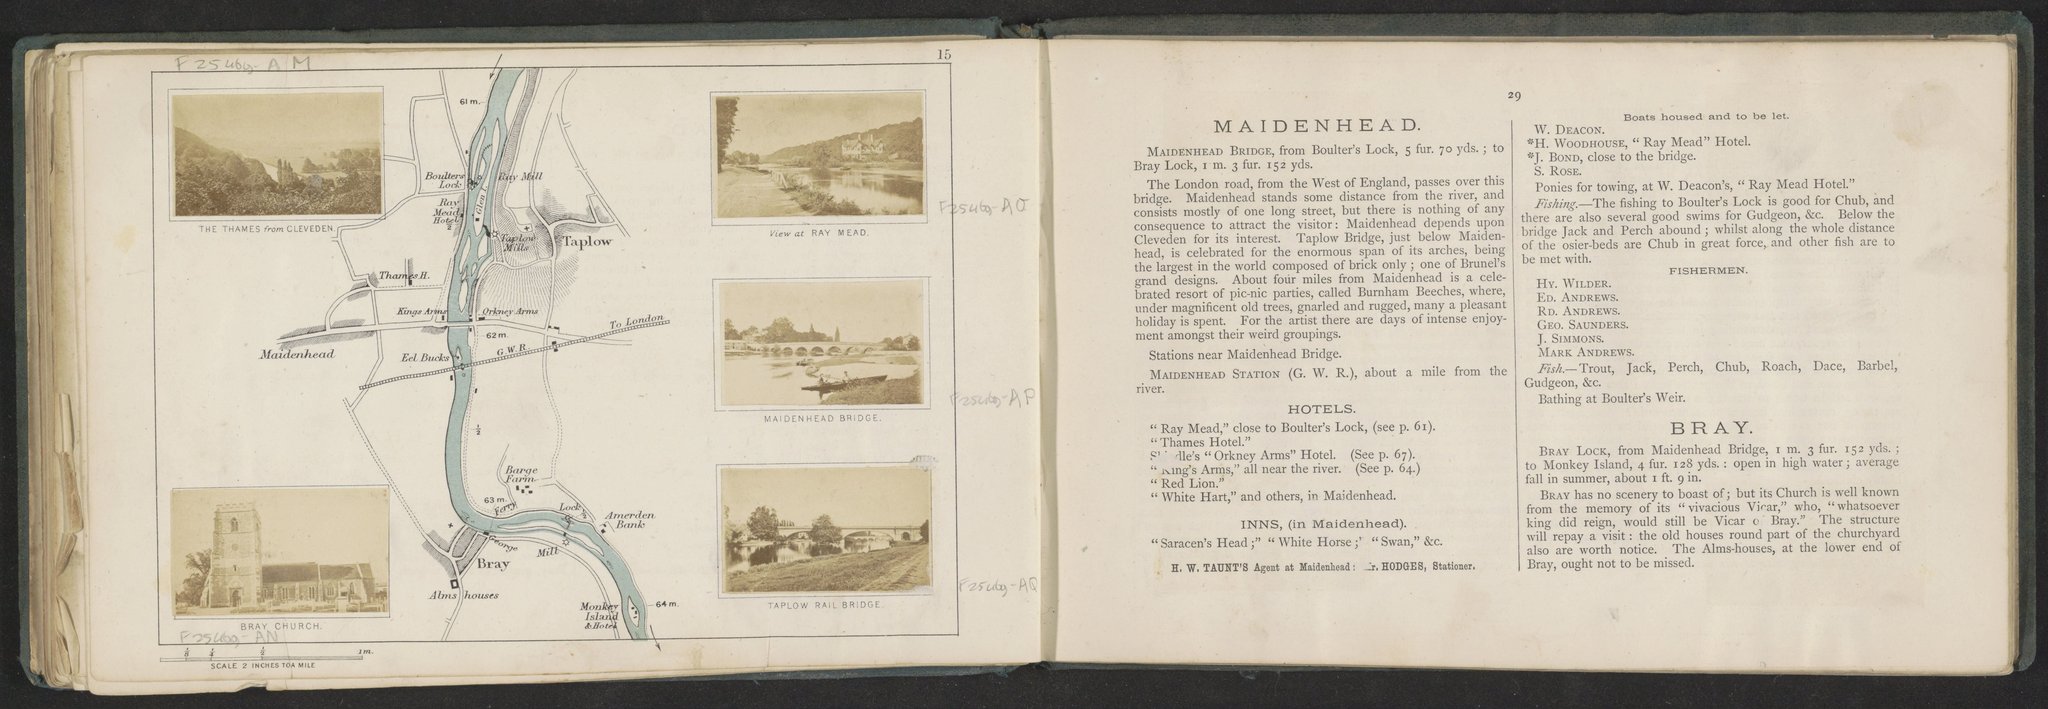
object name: page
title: Gezicht op een spoorbrug over de Theems bij Taplow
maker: henry w. taunt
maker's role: fotograaf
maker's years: 1842-1922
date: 1871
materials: photographic support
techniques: albumen print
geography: taplow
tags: river, bridge, thames